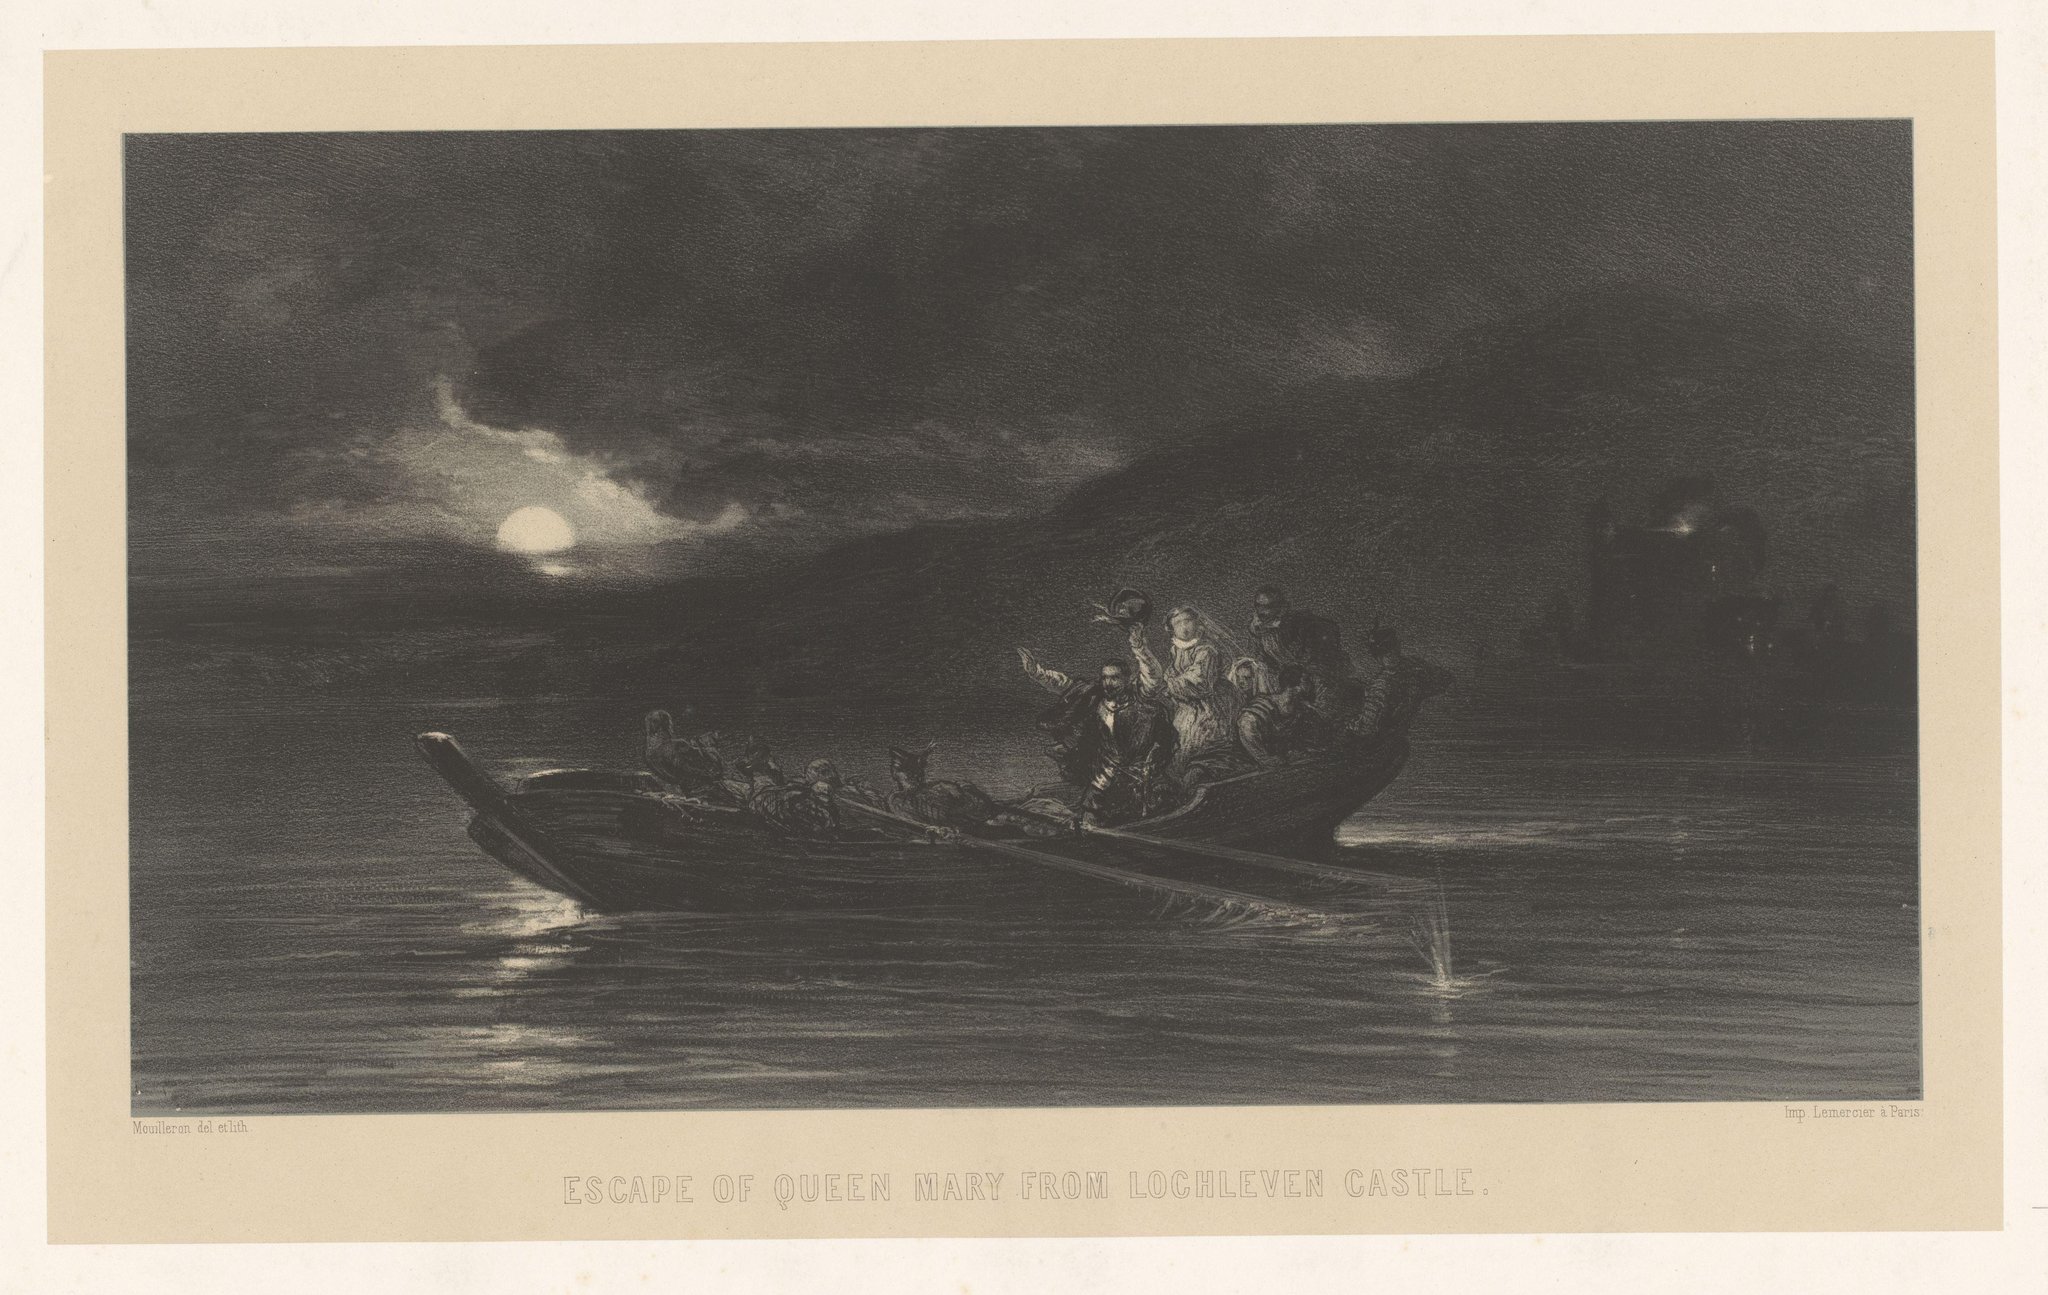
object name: print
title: Escape of queen Mary from Lochleven Castle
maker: joseph rose lemercier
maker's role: printer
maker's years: 1803-1887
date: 1830-1881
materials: paper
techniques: lithograph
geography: paris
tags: rowing-boat, canoe, etc.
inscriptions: collector's mark: Lugt 2228